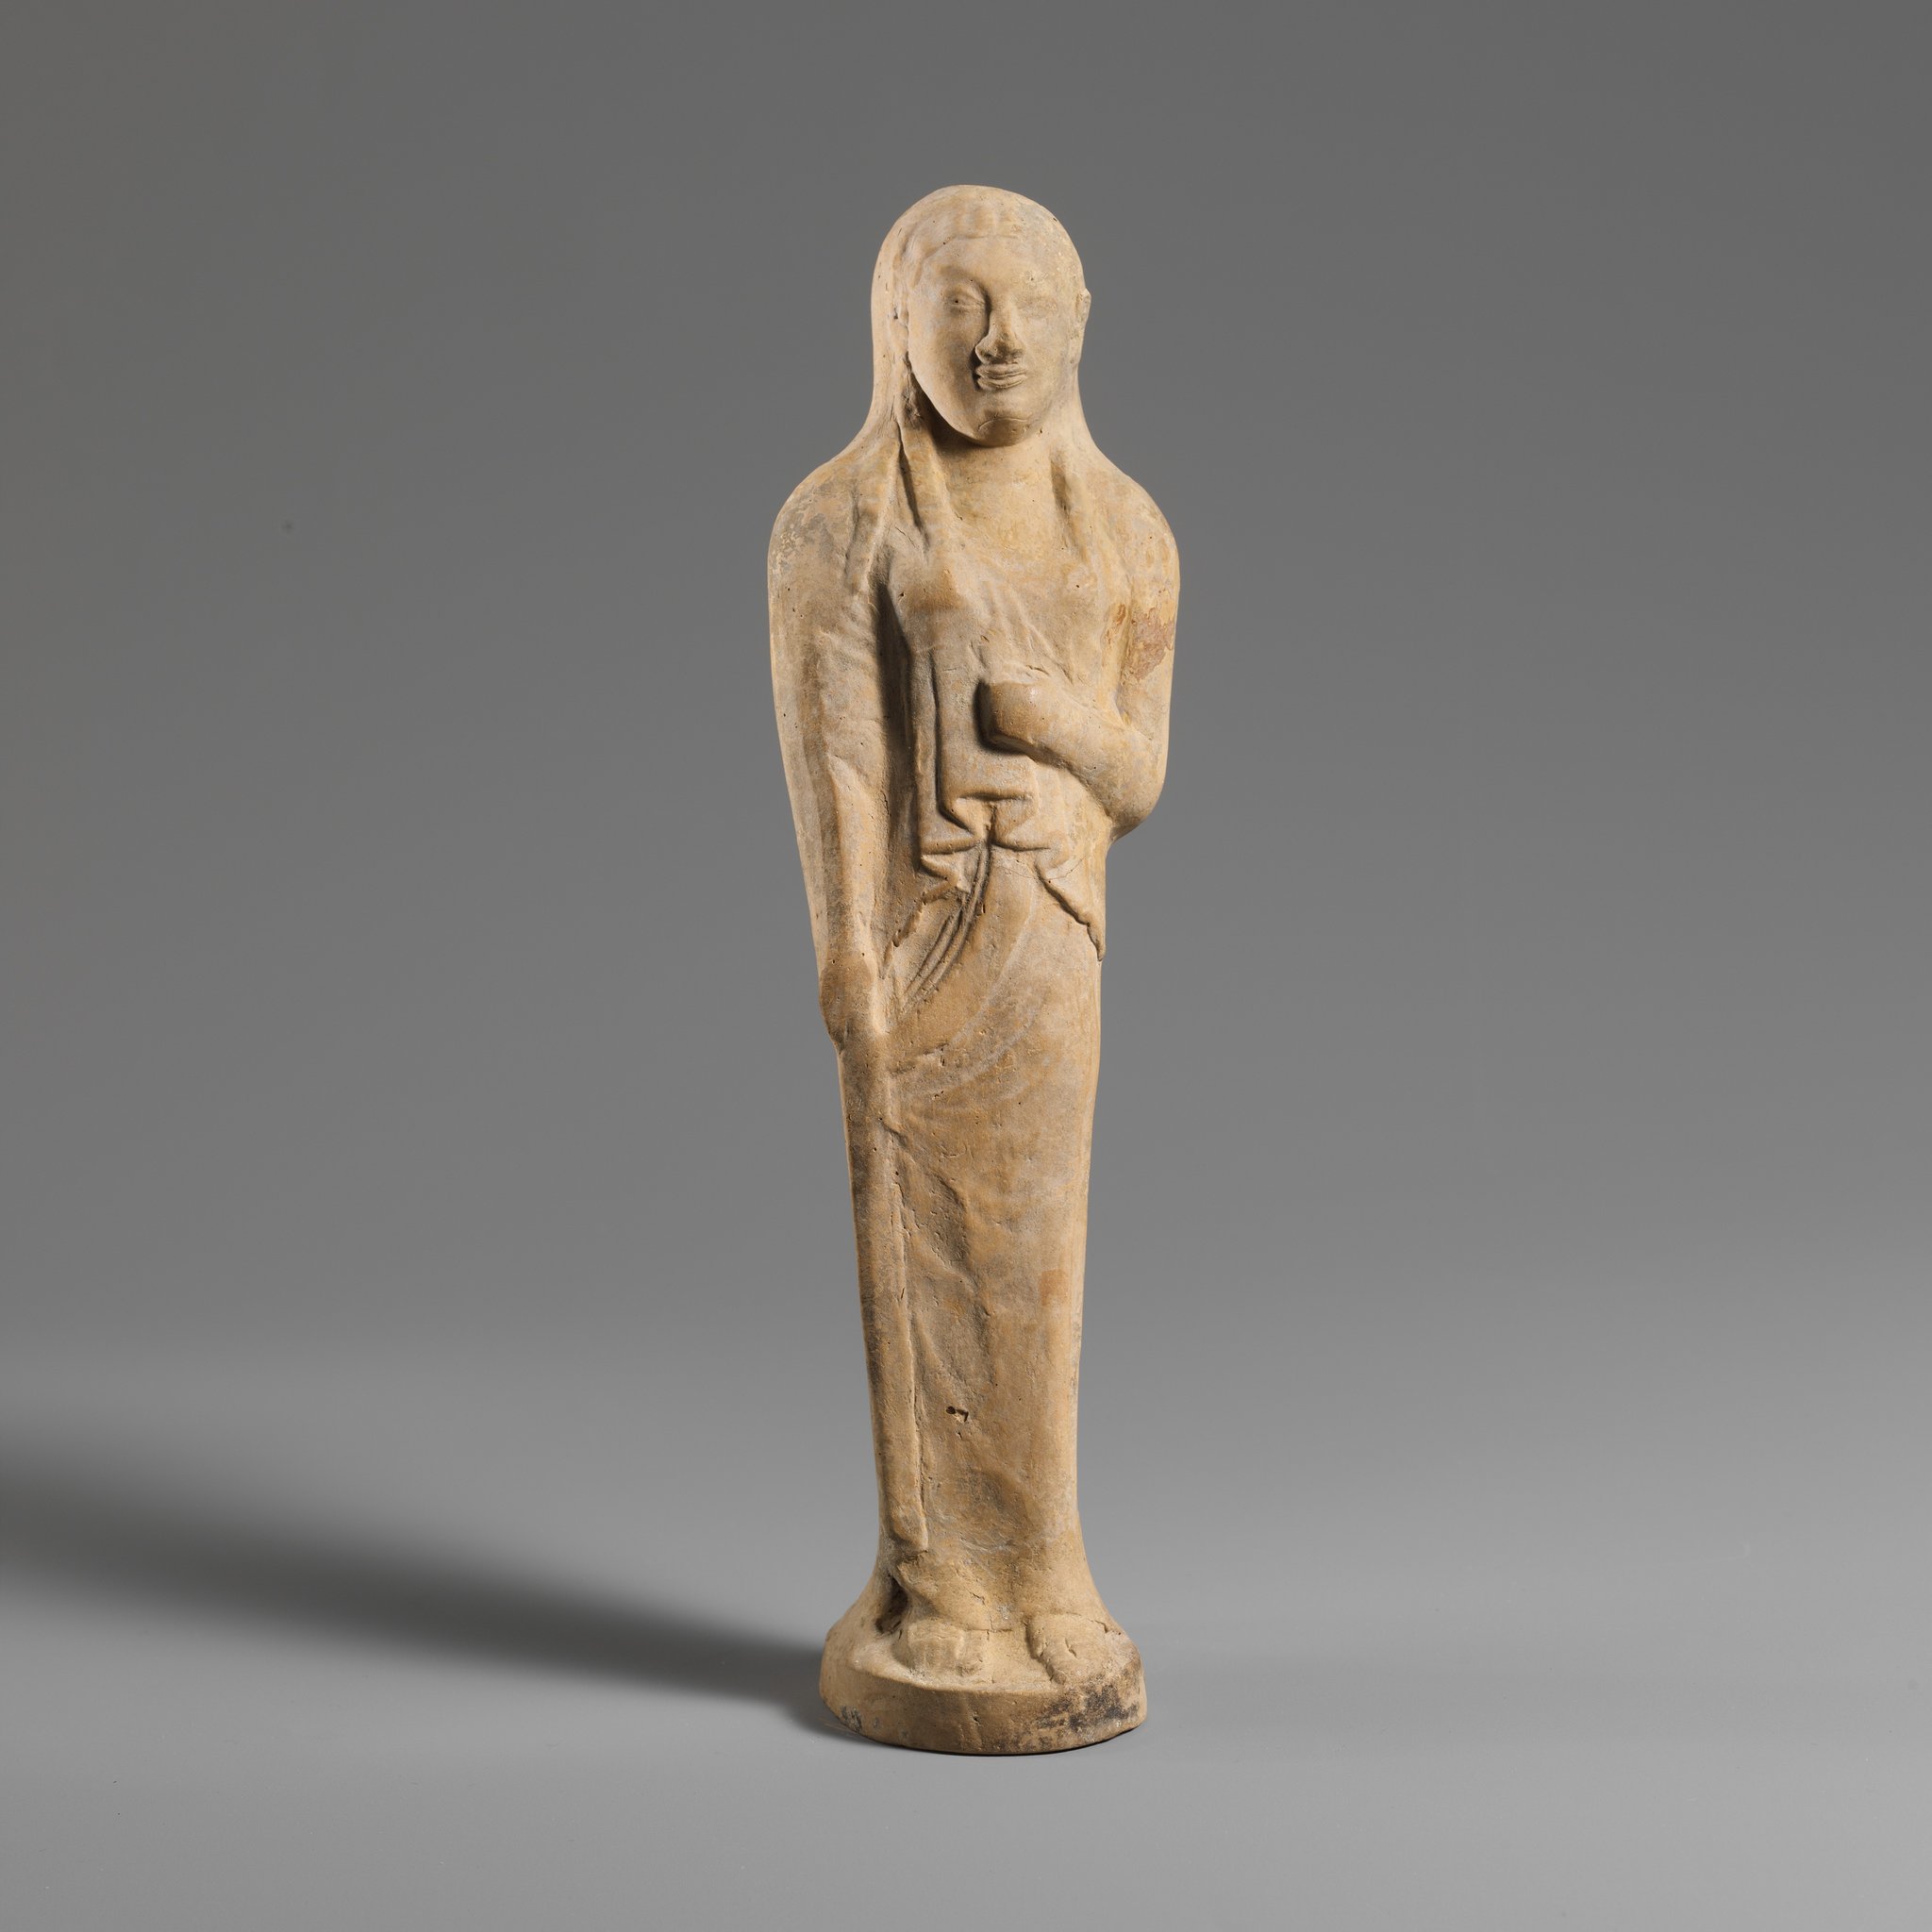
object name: statuette of a girl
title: Terracotta statuette of a young woman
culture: east greek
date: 600-501 BCE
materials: terracotta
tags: women